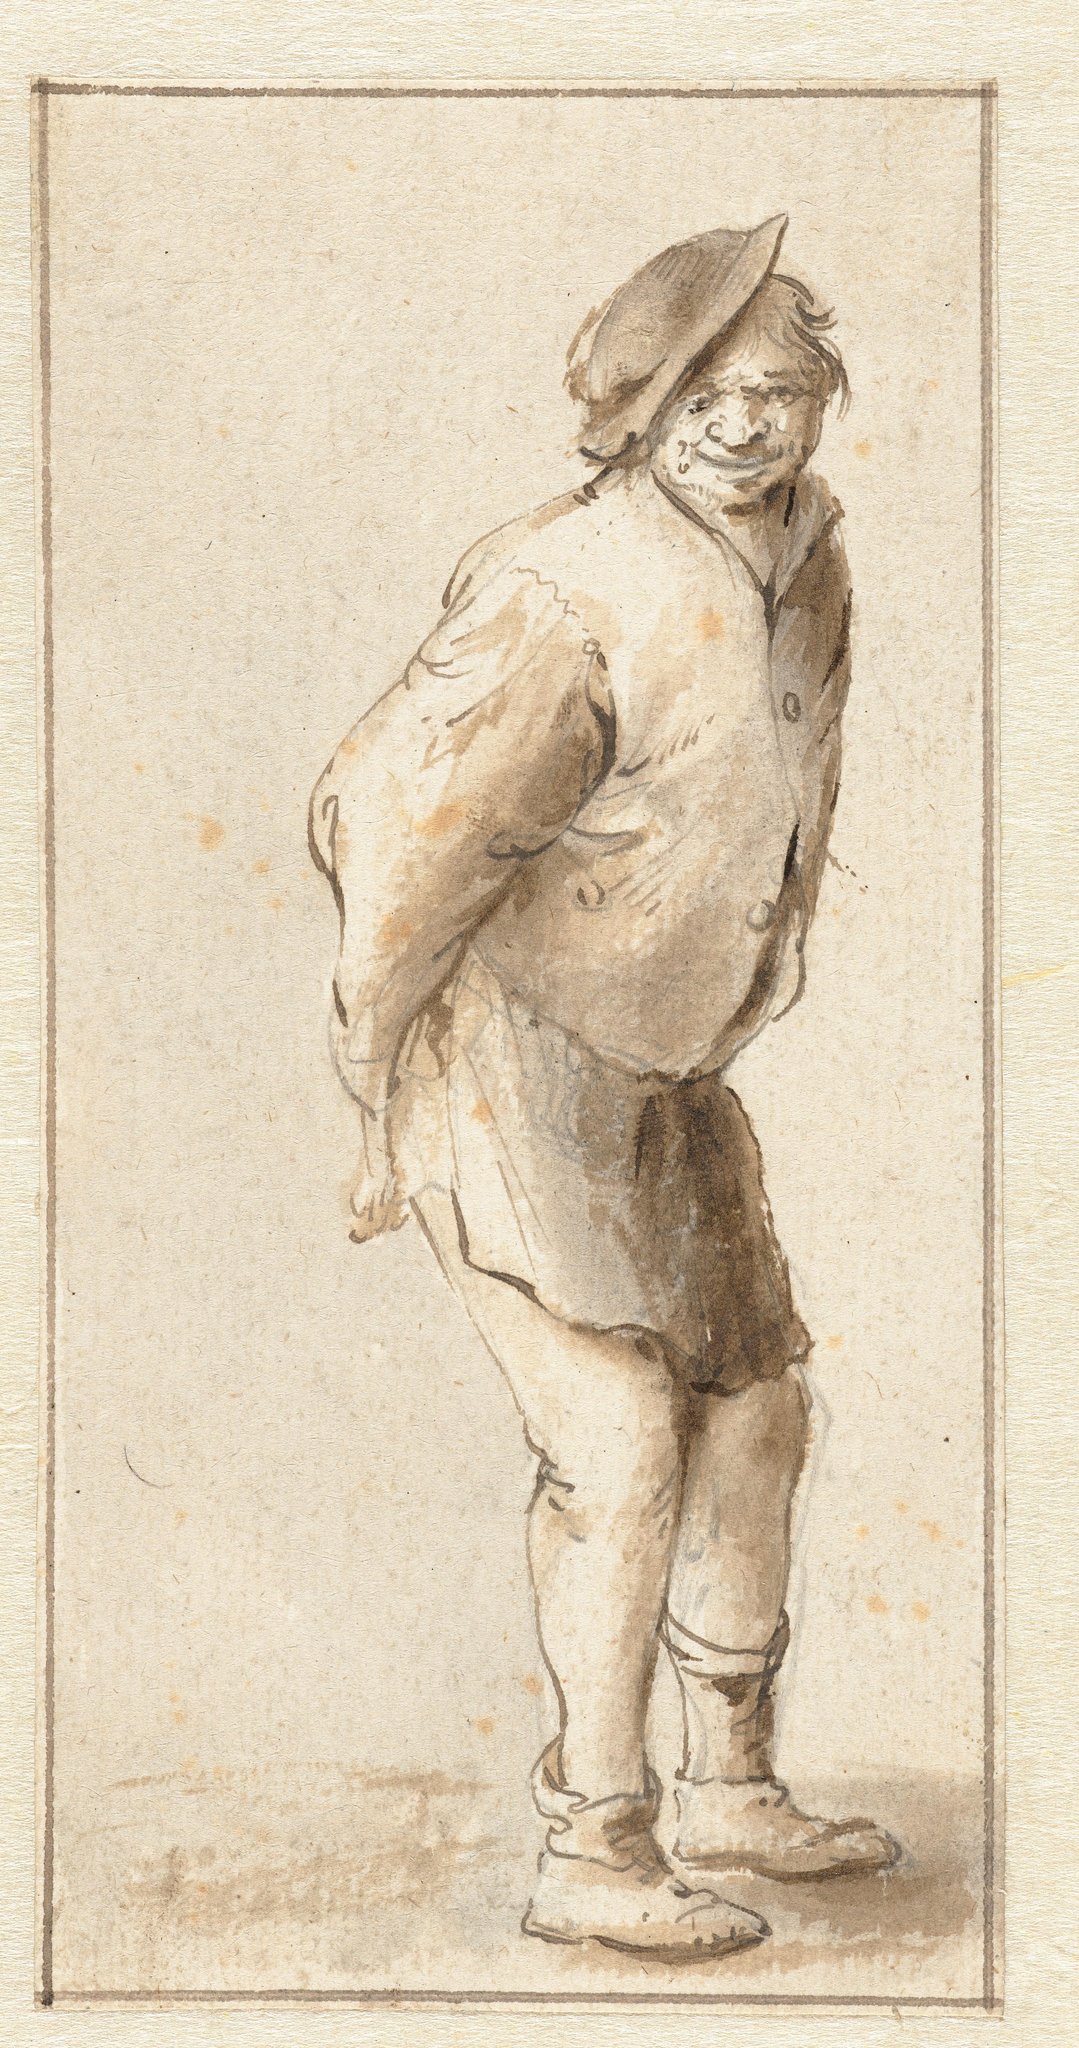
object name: drawing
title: Staande man, iets gebogen met de handen op de rug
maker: isaac van ostade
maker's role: draughtsman, painter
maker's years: 1621-1649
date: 1631-1649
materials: ink, paper, pencil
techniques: brush, pen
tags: standing figure, farmers